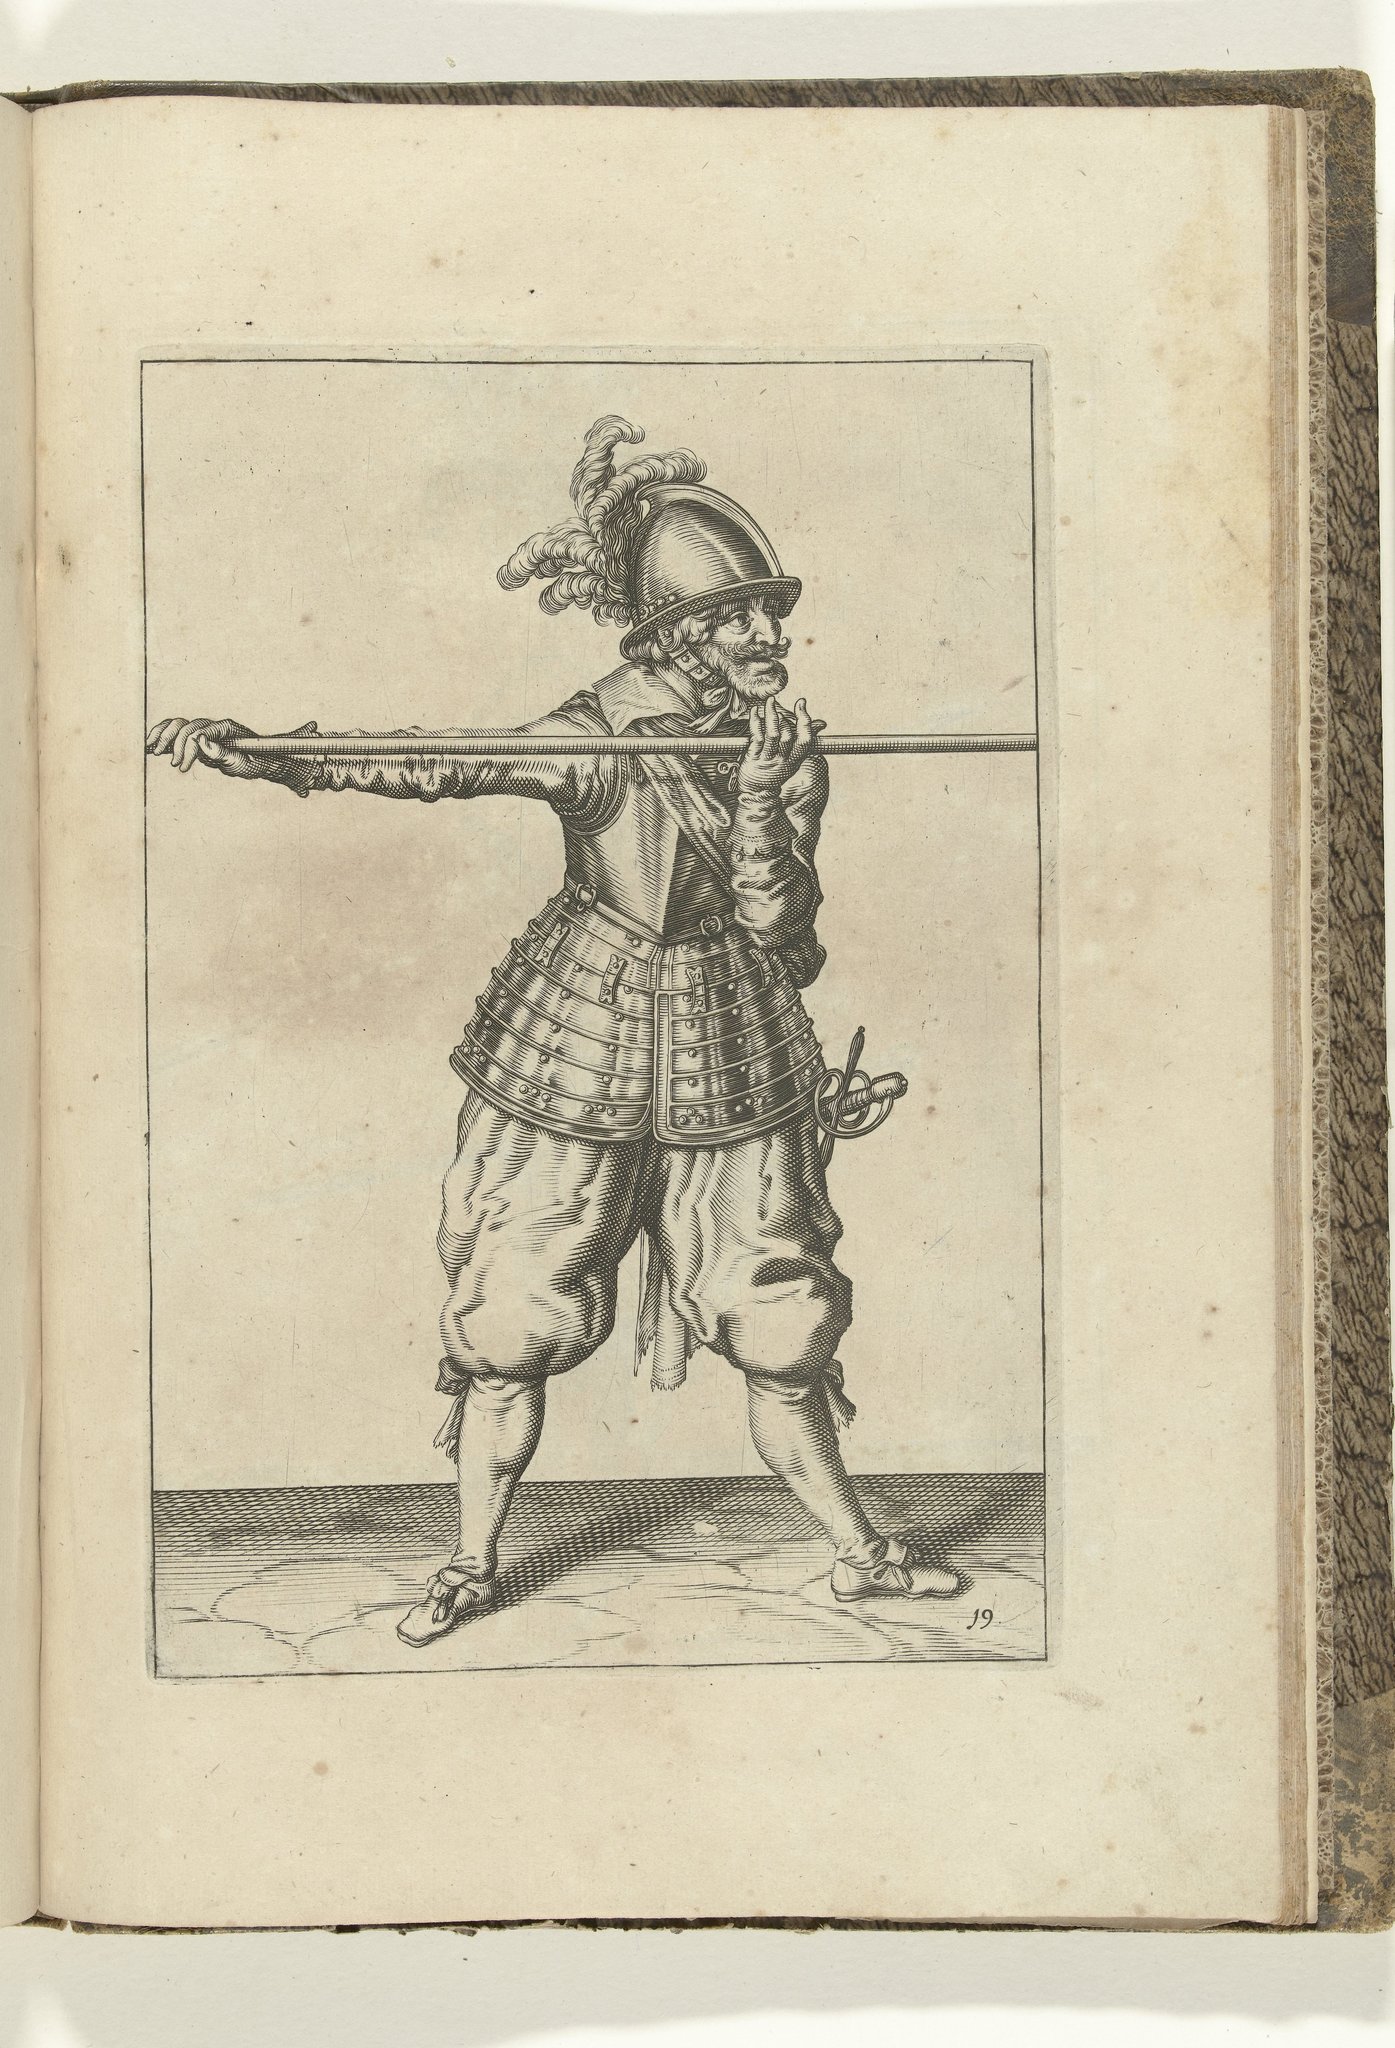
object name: print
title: Soldaat die zijn spies met beide handen horizontaal op schouderhoogte draagt (nr. 19), ca. 1600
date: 1597-1608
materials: paper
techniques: engraving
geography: amsterdam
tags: maurice (prince of orange), handling of weapons ~ military training, weapons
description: Een soldaat, ten voeten uit, die een spies (lans) met beide handen horizontaal op schouderhoogte draagt (nr. 19), ca. 1600. Plaat 19 in de instructies voor het hanteren van de spies: Enseignement brief; et succint sur les portraitz figurez, touchant l'usage, de tout ce qu'un Soldat doibt faire au maniement de la Pique. Onderdeel van de illustraties in een Franse editie van J. de Gheyns Wapenhandelinghe: J. de Gheyn, Maniement d'armes, d'arquebuses, mousquetz et piques : en conformité de l'ordre de Mour le Prince Maurice, Prince d'Orange, Amsterdam 1608. Krijgswezen rond 1600.